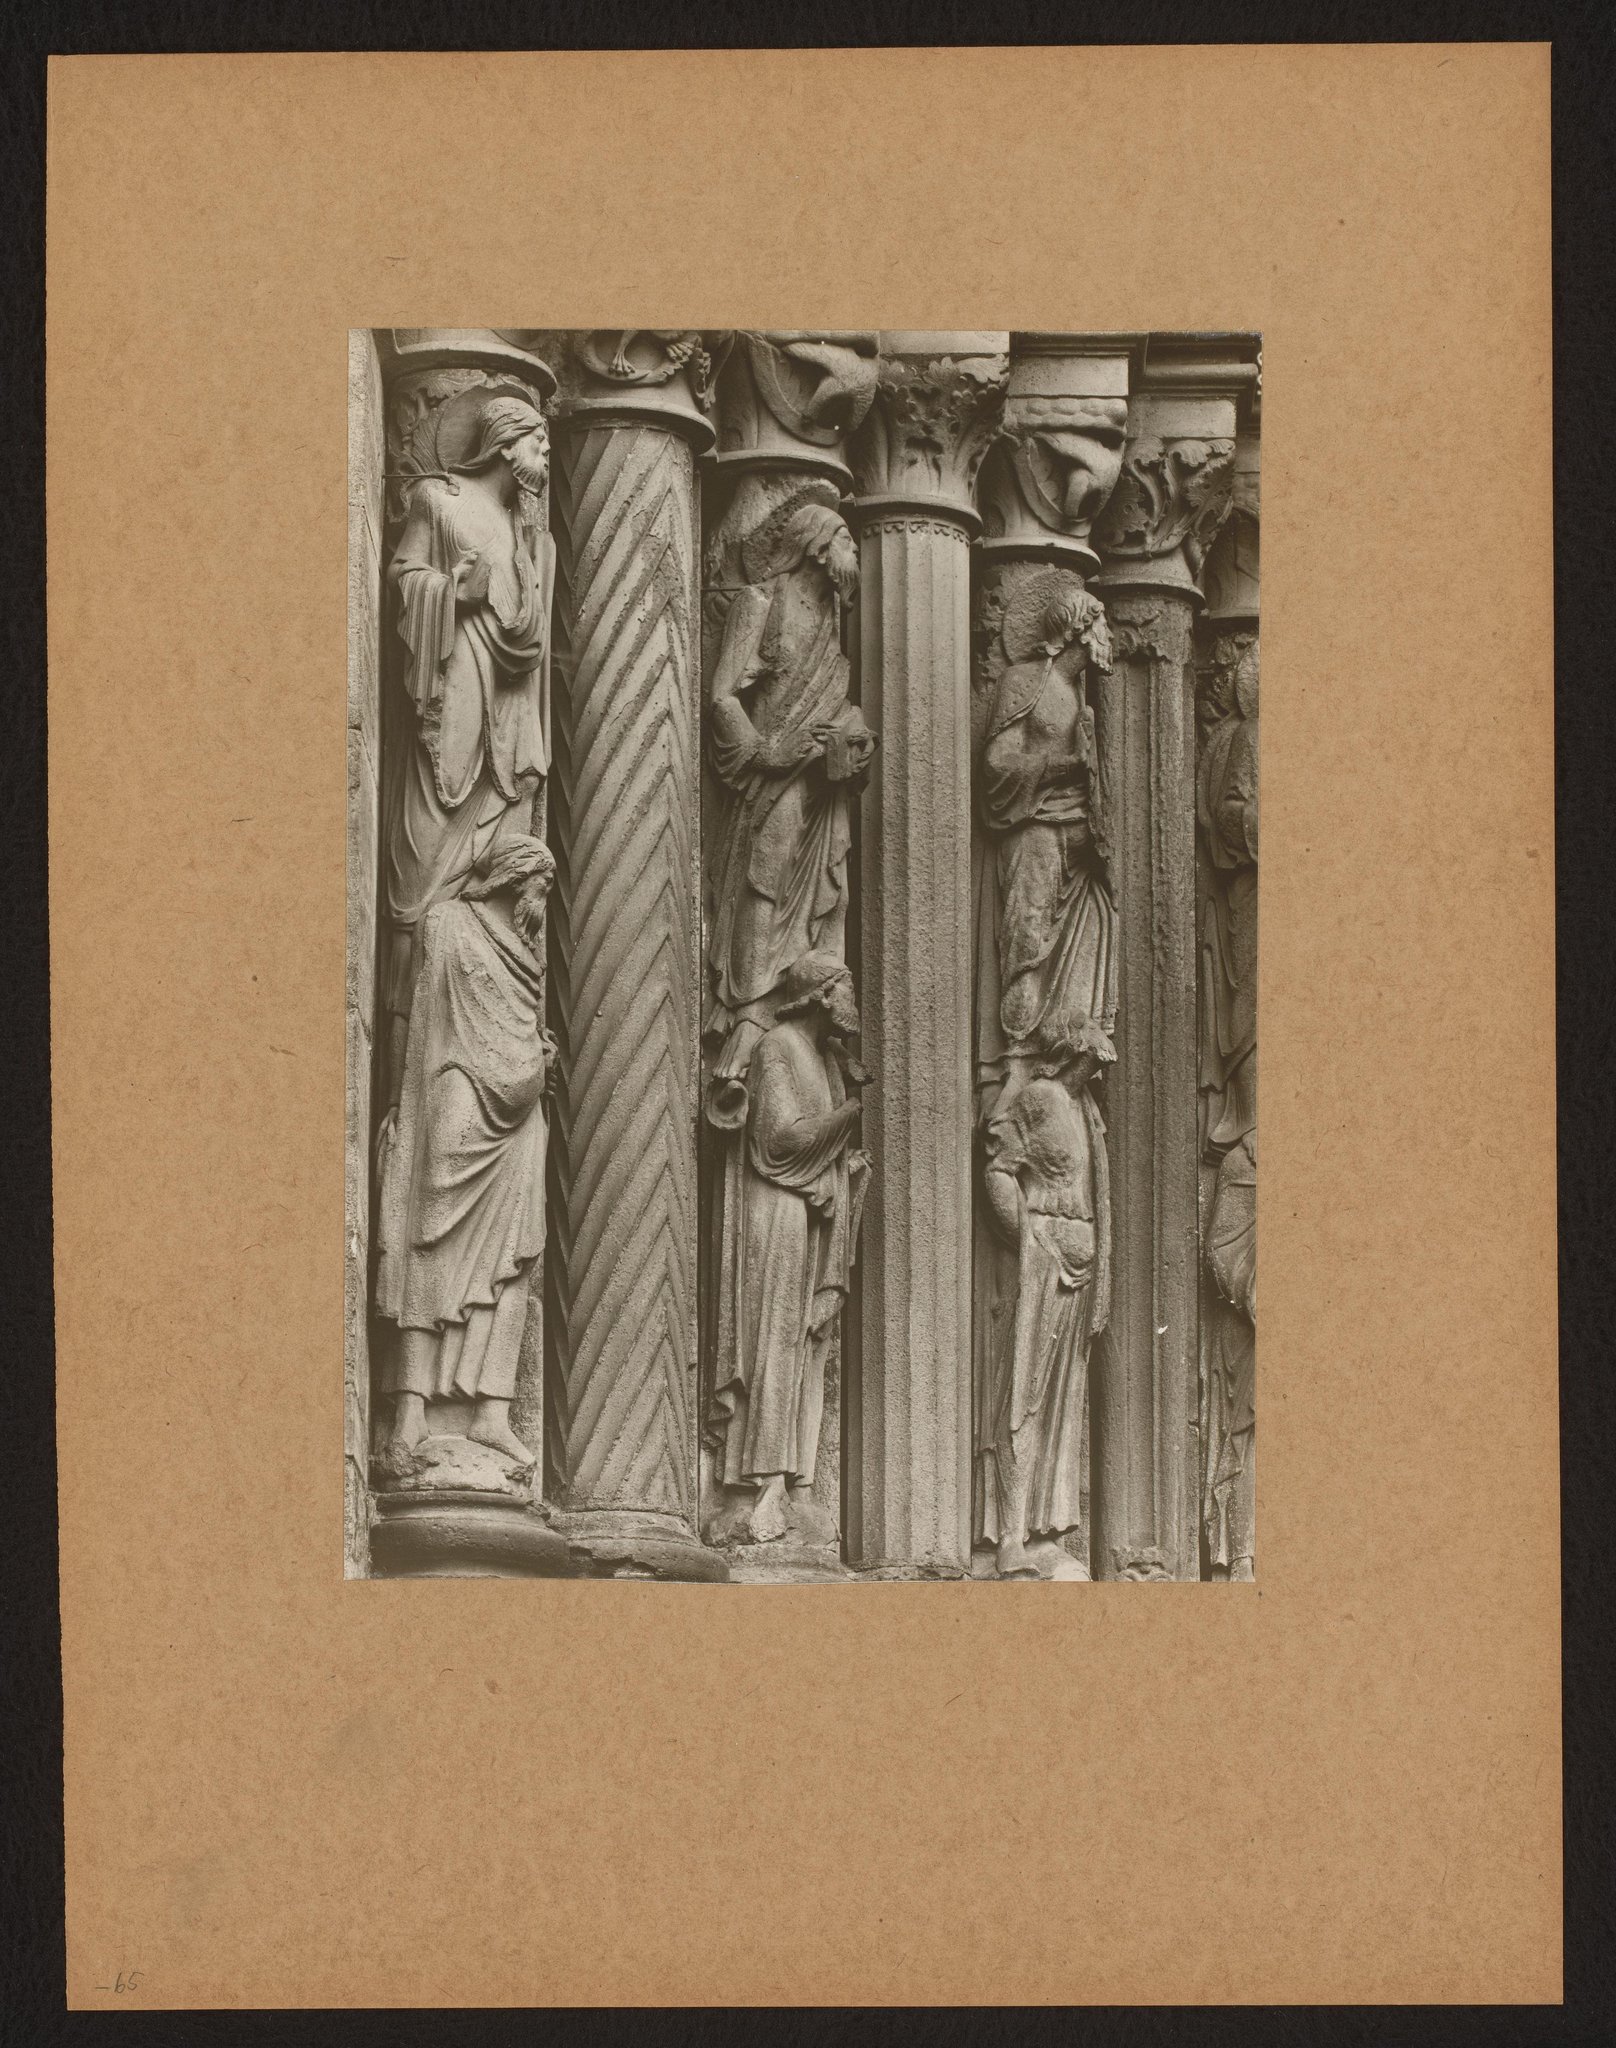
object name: photograph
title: Detail van de Fürstenportal in de dom van Bamberg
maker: Anonymous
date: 1900-1920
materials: paper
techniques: gelatin silver print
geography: bamberg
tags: church (exterior)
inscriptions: number: ‘66’